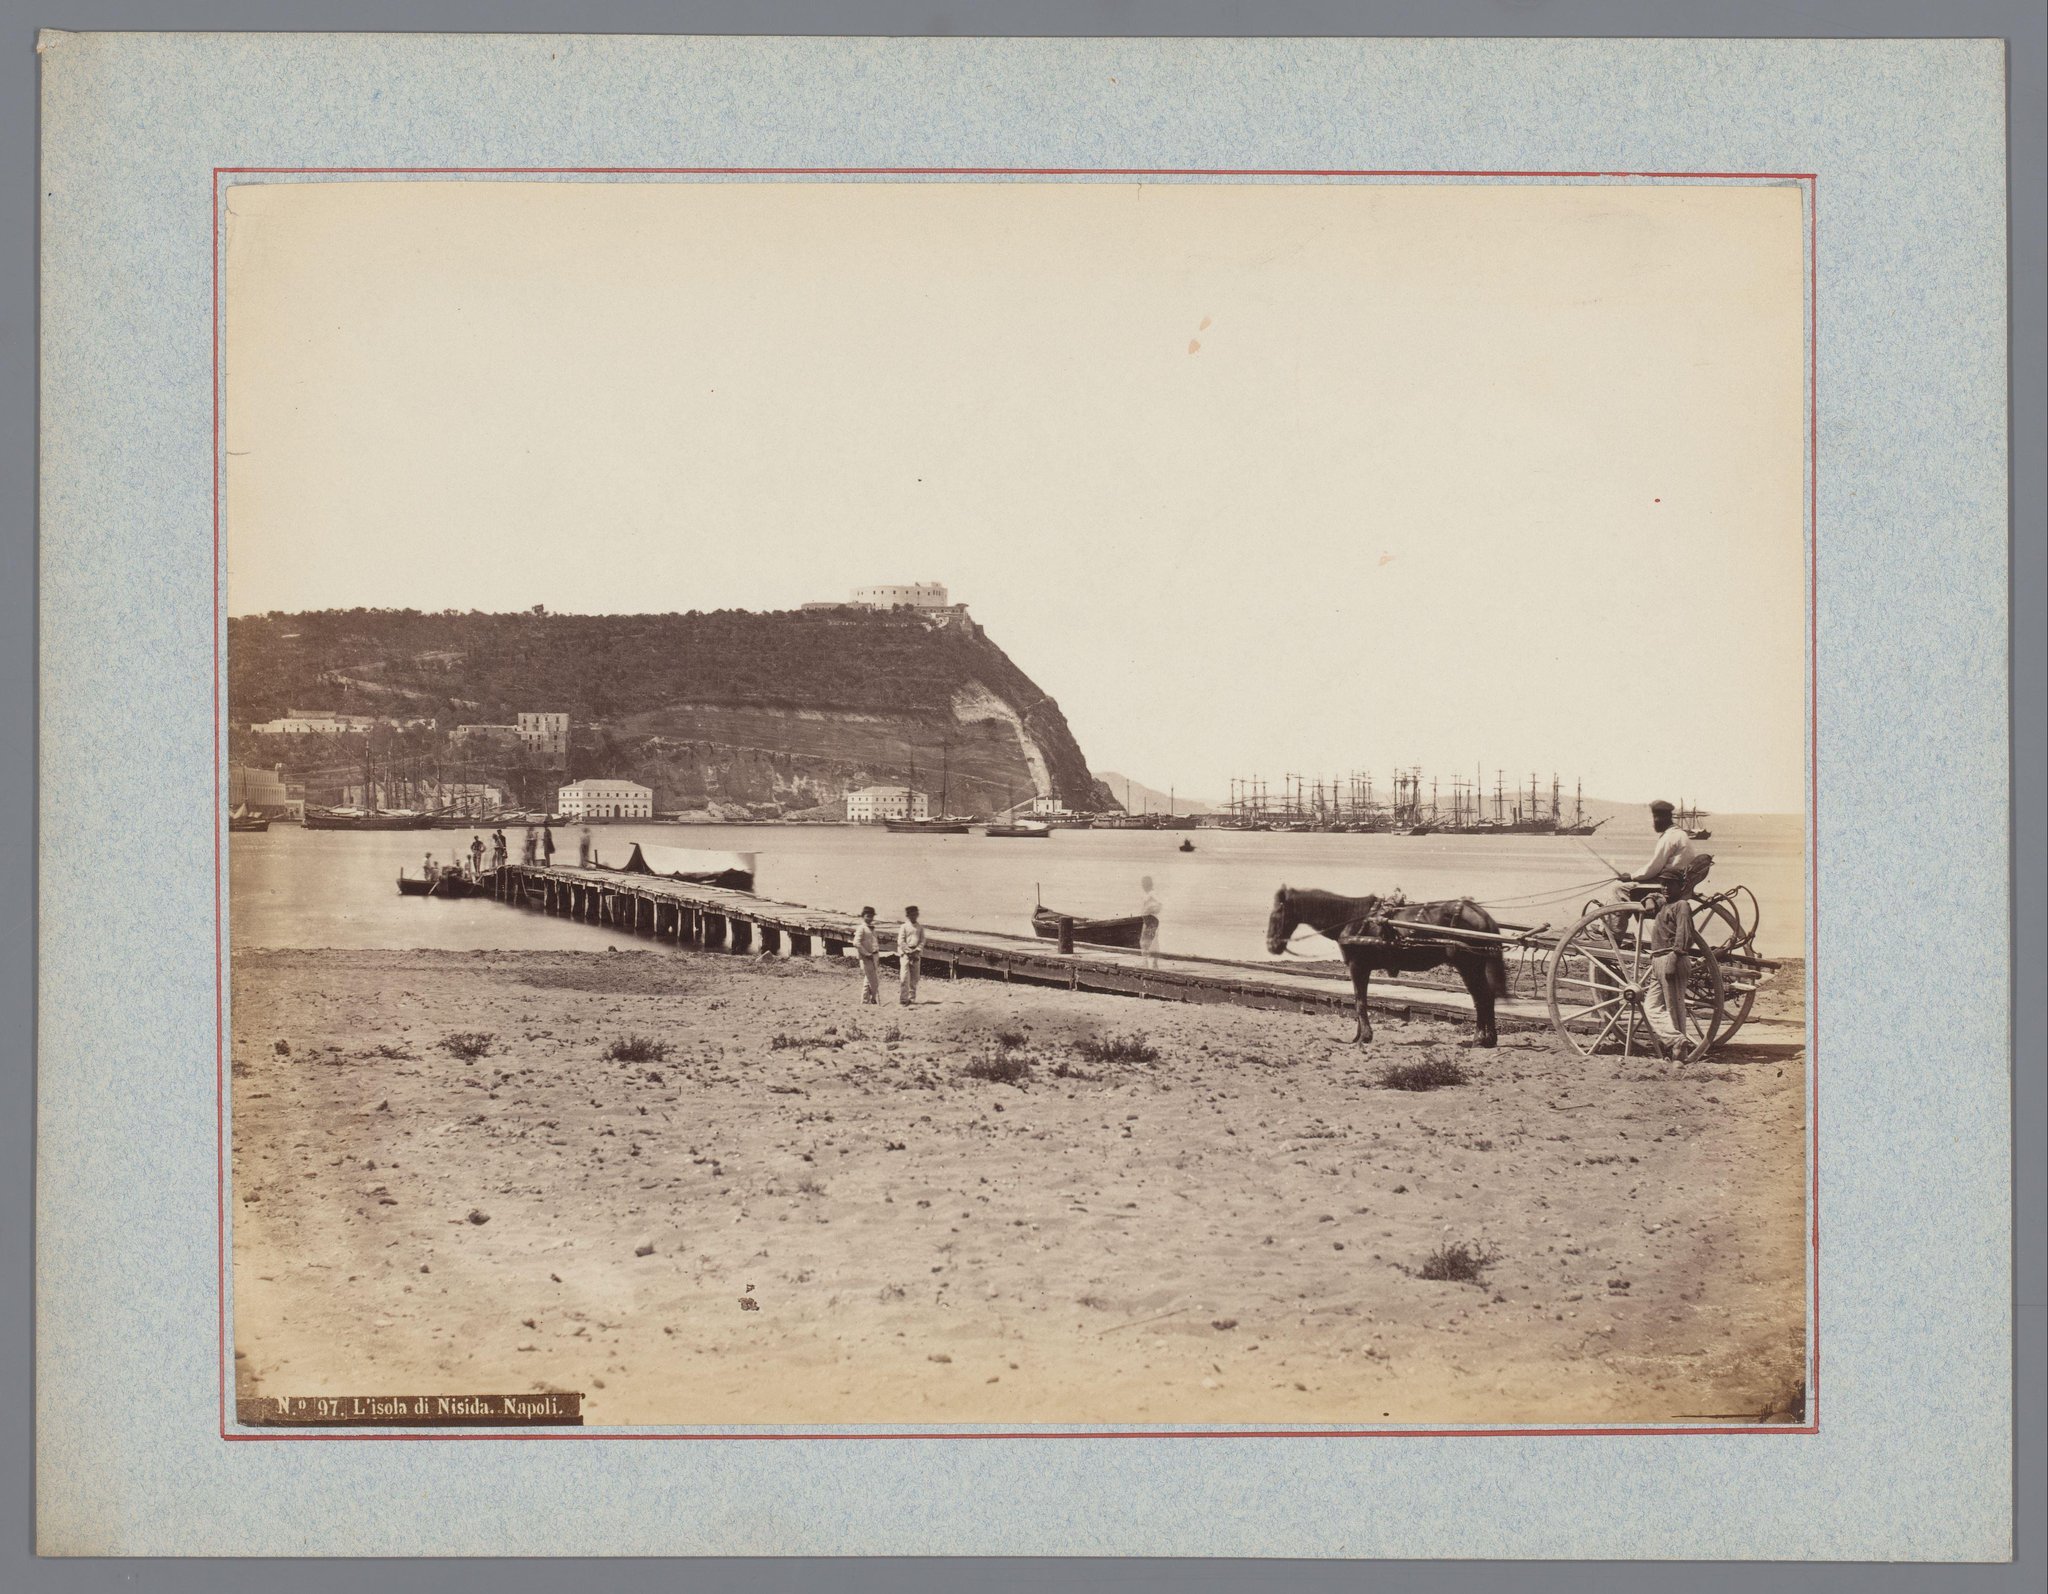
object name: photograph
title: Gezicht op het eiland Nisida in de baai van Napels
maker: roberto rive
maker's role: fotograaf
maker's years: 1825-1868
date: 1860-1889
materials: cardboard, paper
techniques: albumen print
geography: naples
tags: island, two-wheeled, animal-drawn vehicle, beach, nisida, isola di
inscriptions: number: ‘No. 97’